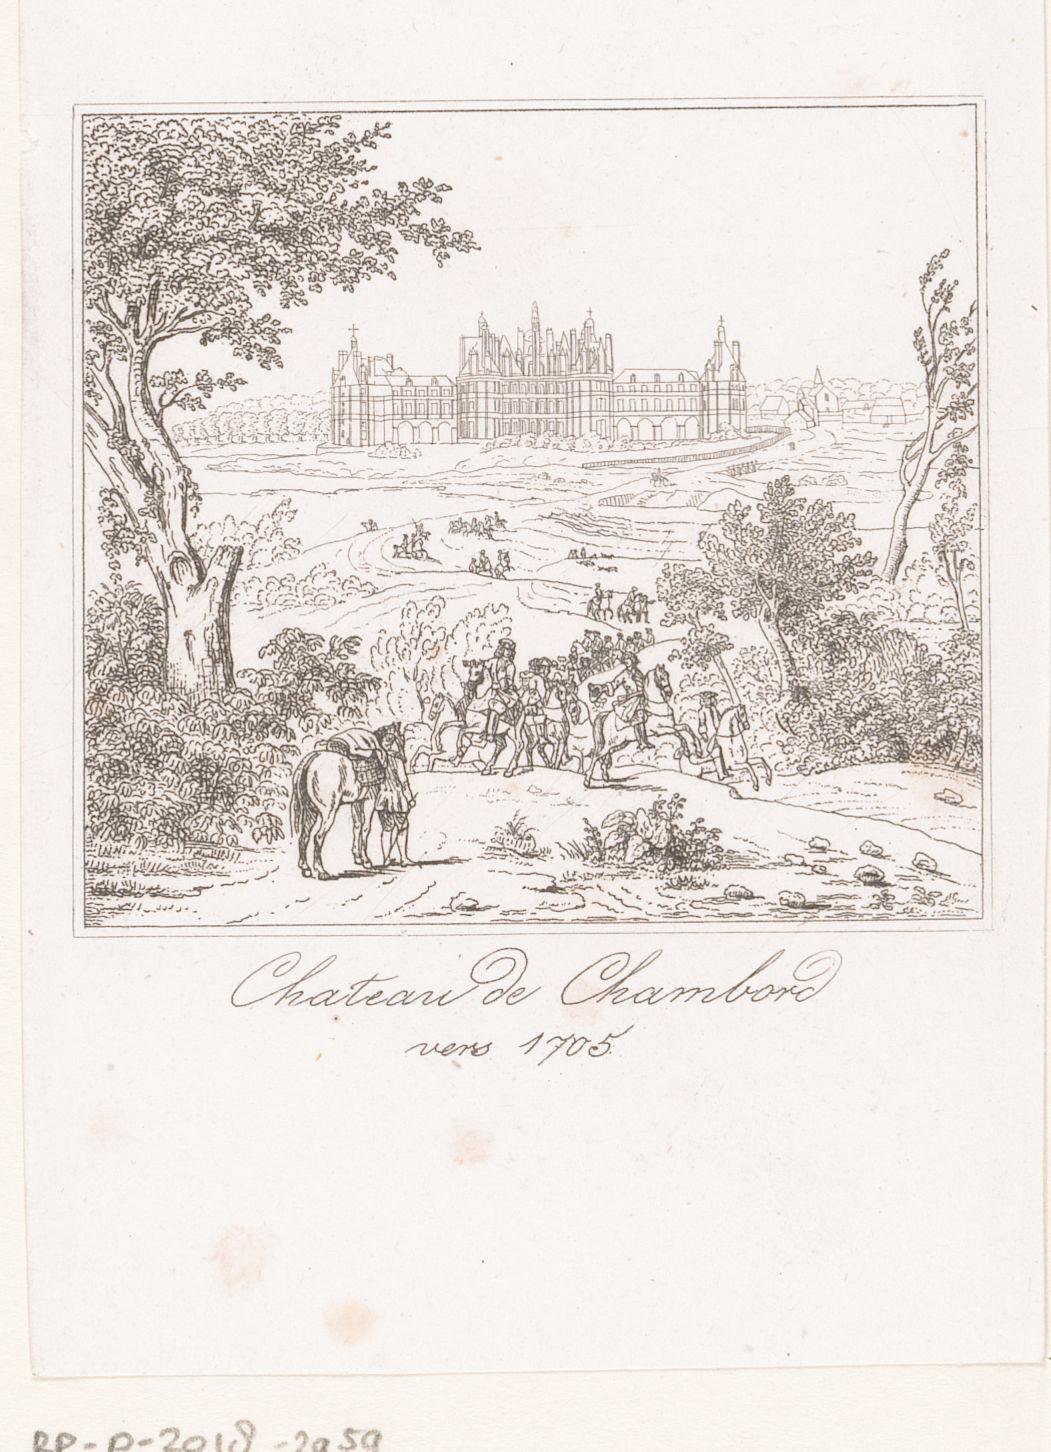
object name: print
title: Château de Chambord rond 1705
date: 1837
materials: paper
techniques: etching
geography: paris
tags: castle, landscape with tower or castle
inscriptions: collector's mark: Lugt 2228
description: Prent verschenen in: Galeries Historiques de Versailles. Parijs: Charles Gavard, 1837.